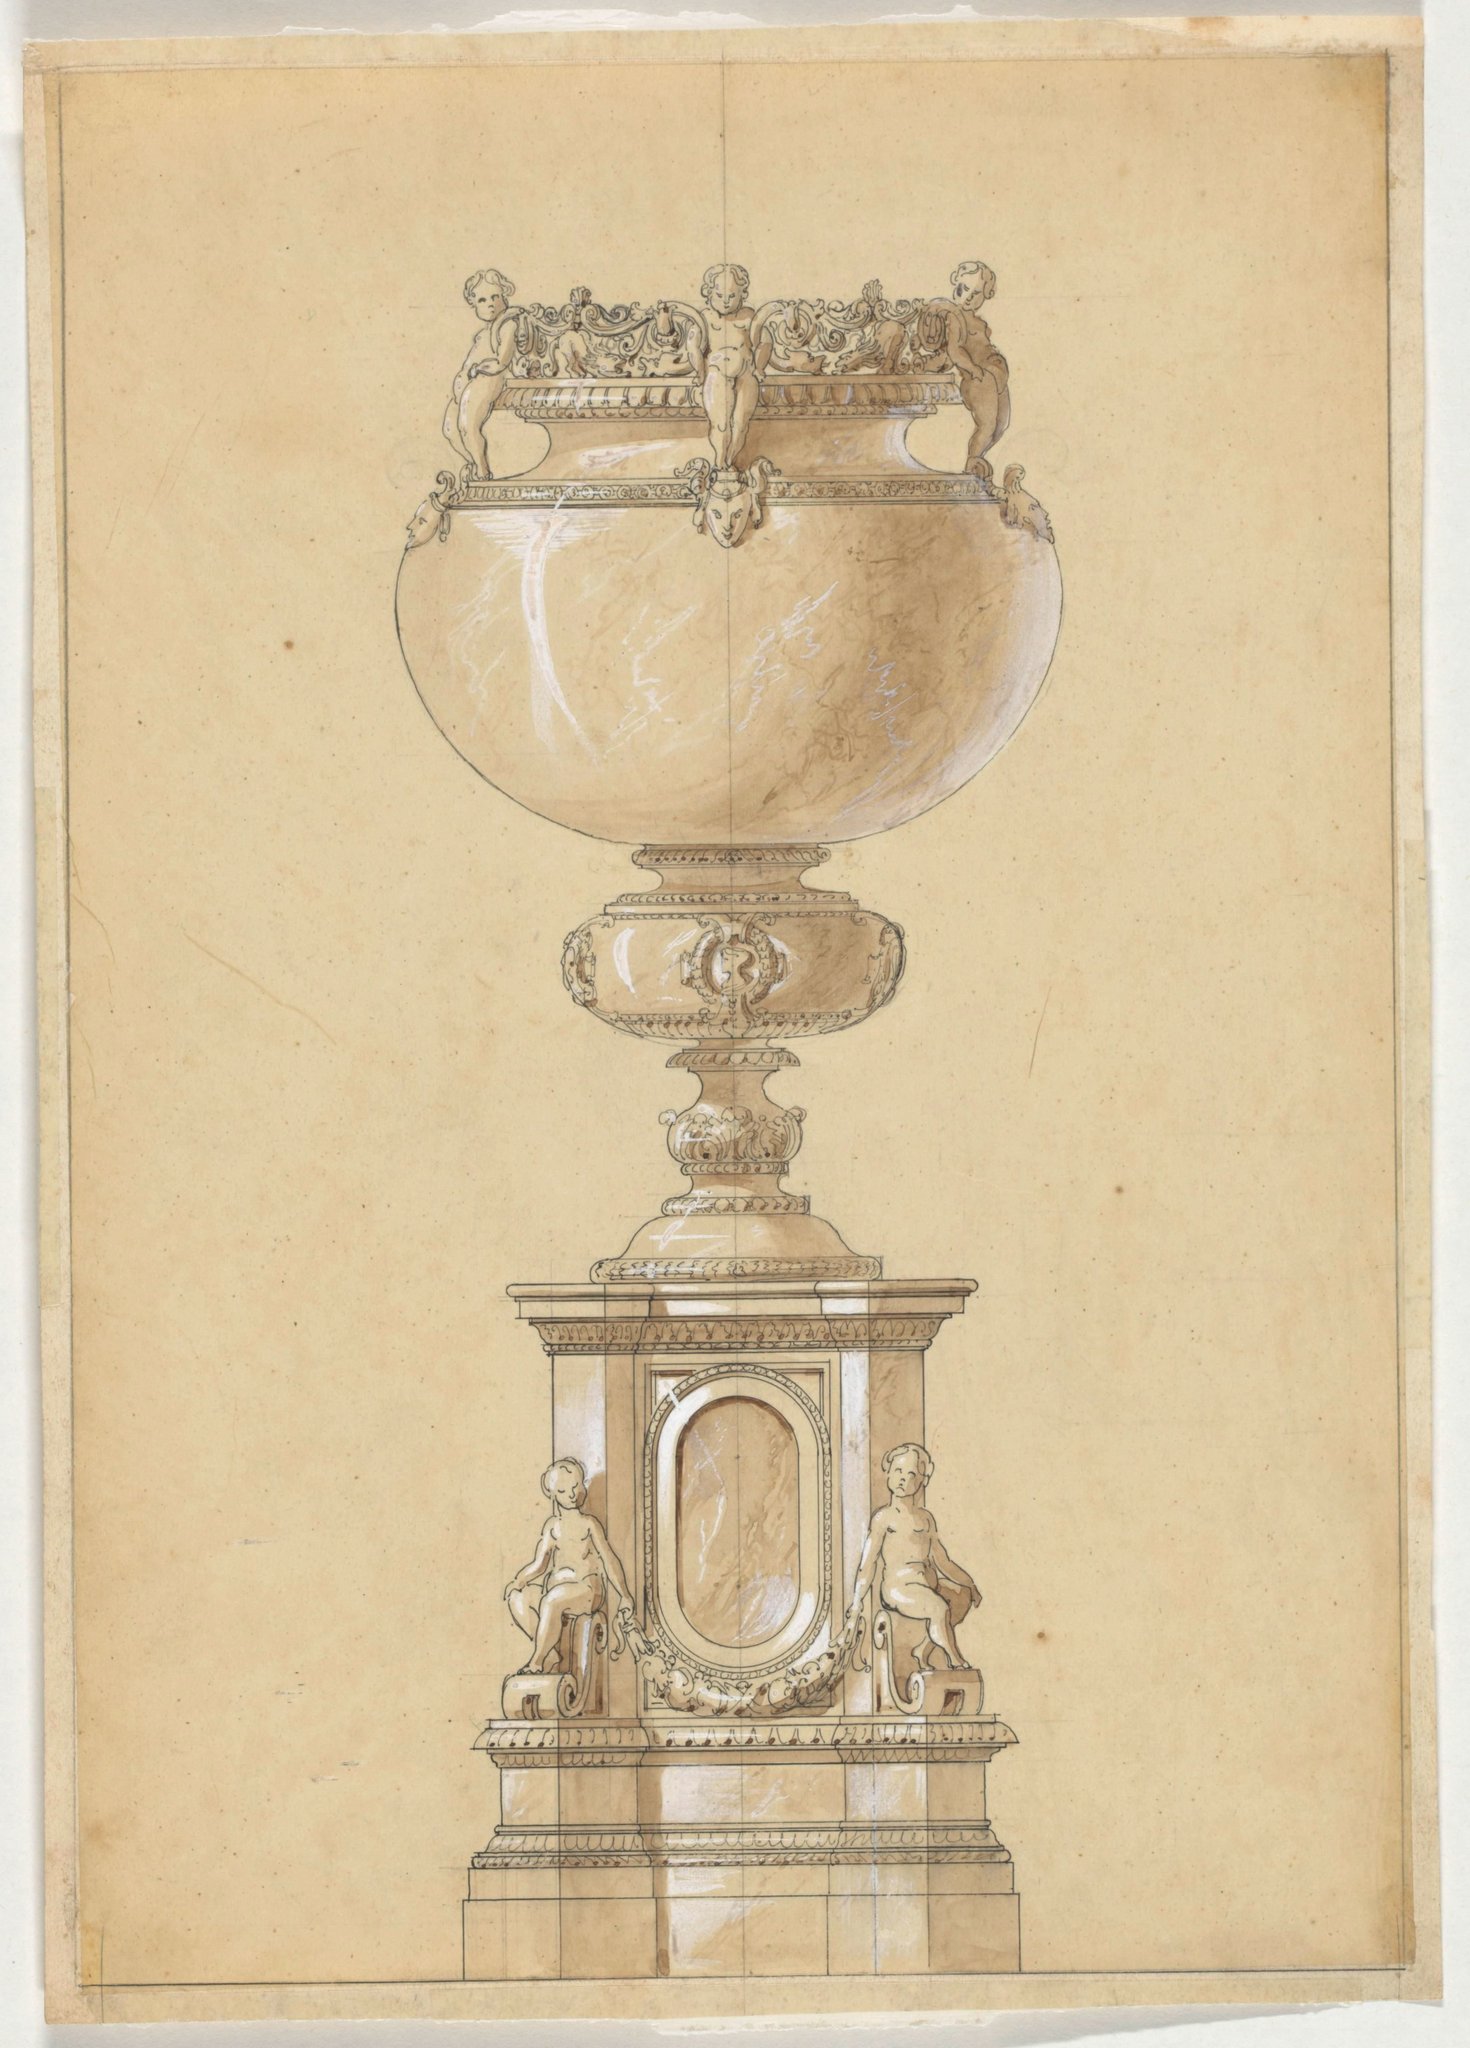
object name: design drawing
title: Vaas op basement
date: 1830-1850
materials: graphite, paper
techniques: pen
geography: paris